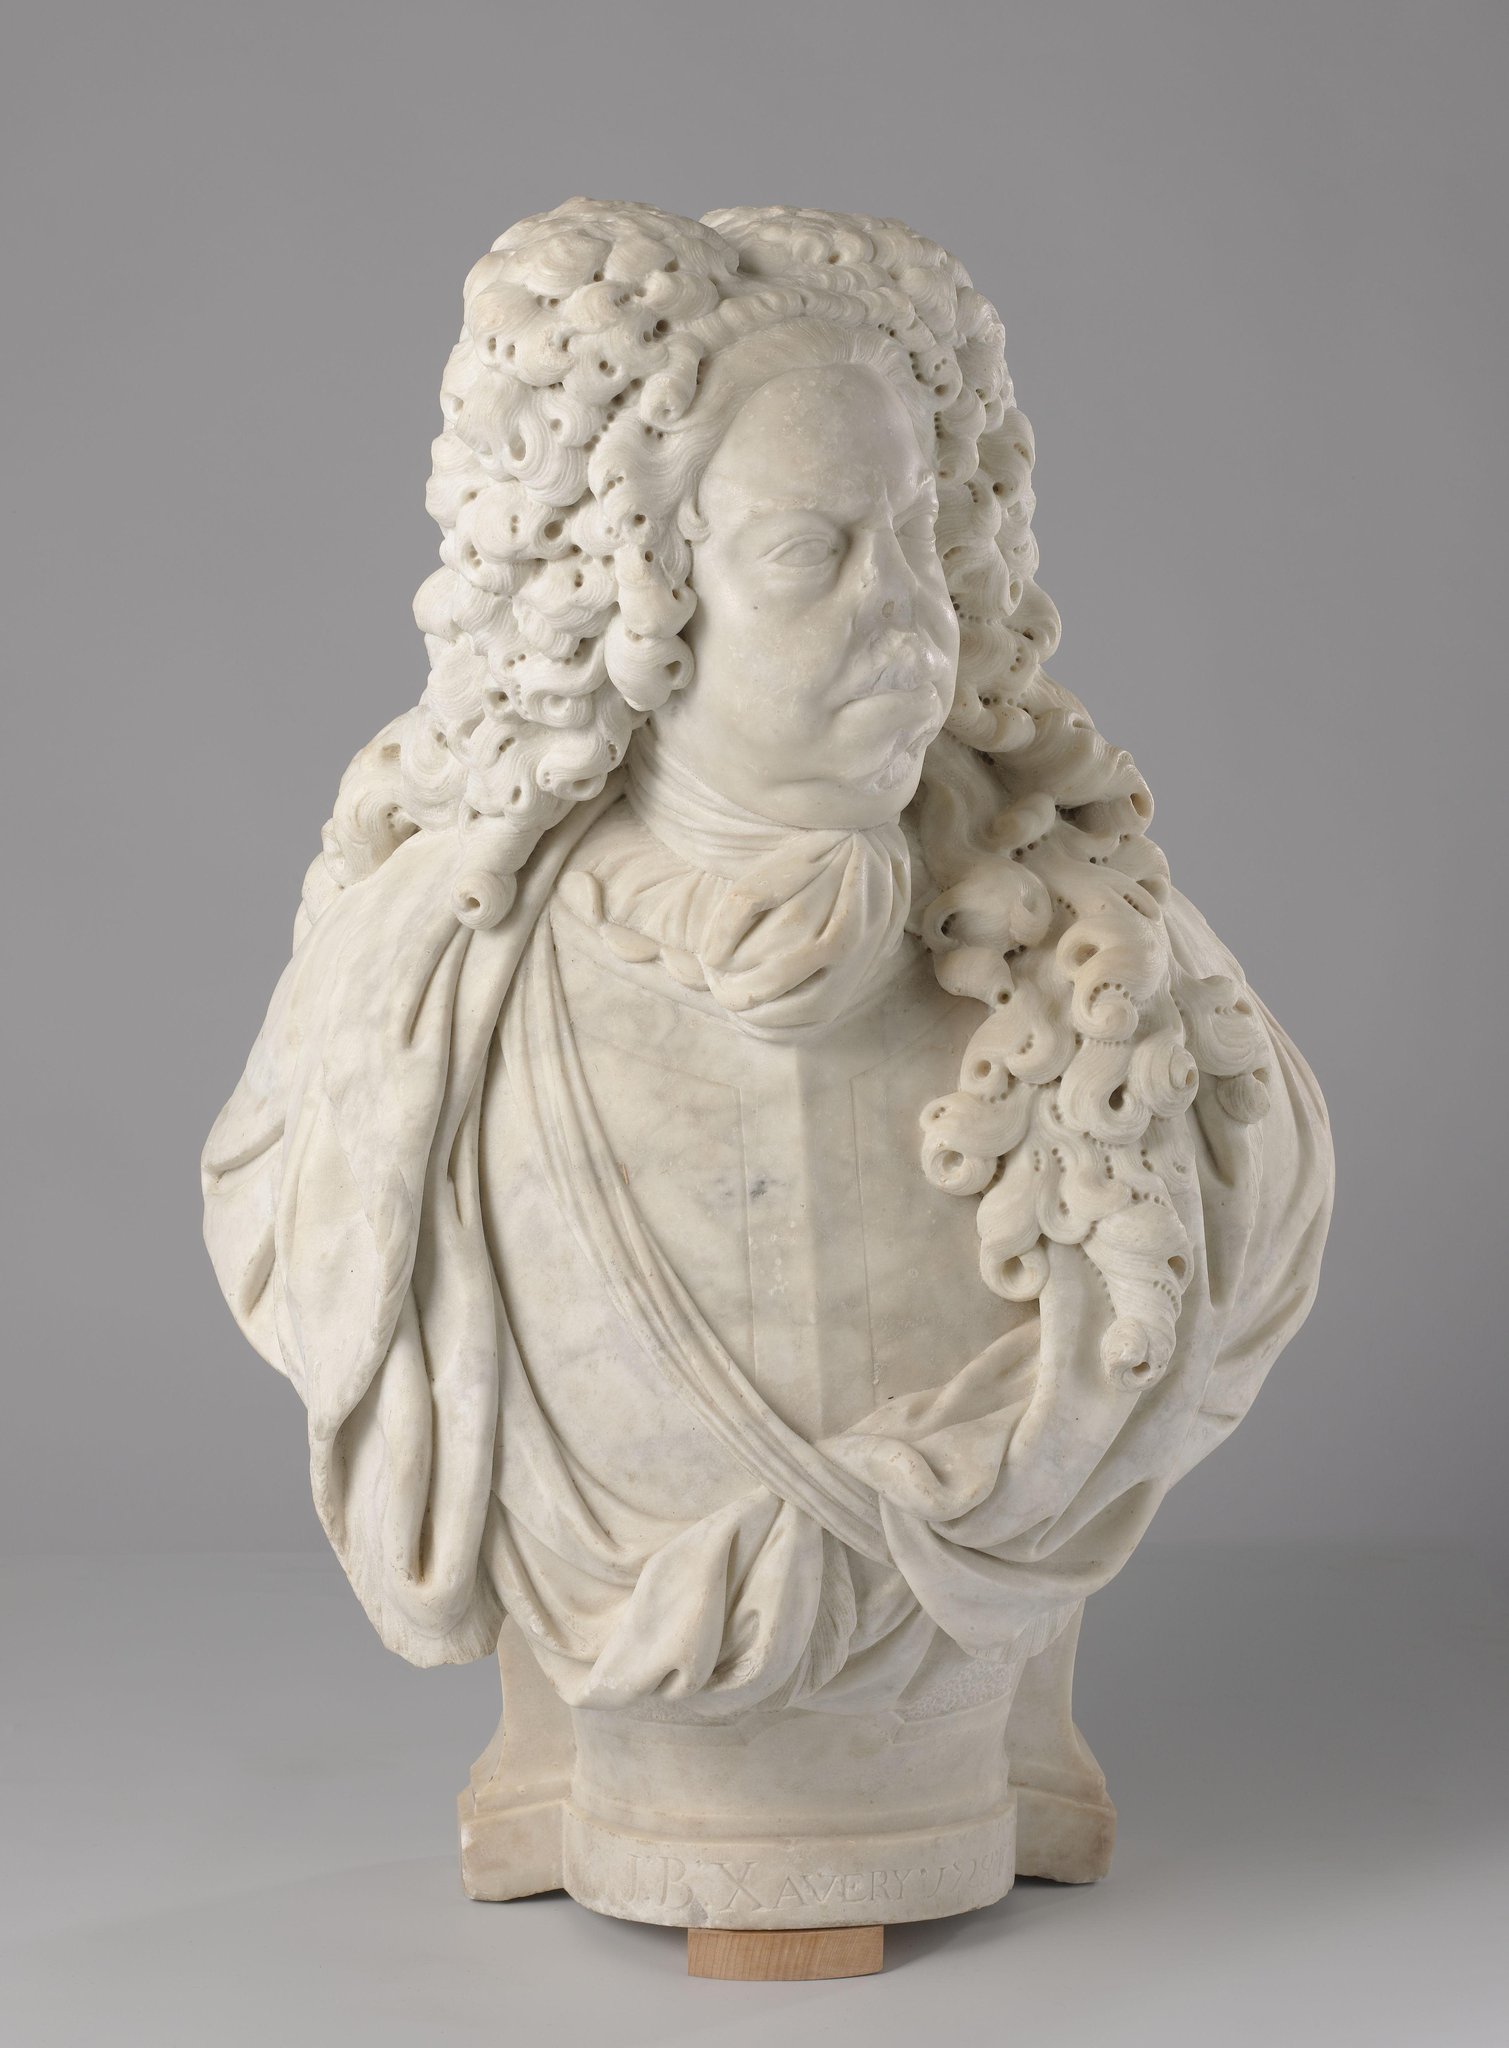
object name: sculpture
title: Bust of Johan van Welderen, Lord of Ubbergen, Valburg and Oudenhoorn (1660-1724)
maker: jan baptist xavery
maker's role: sculptor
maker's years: 1697-1742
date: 1728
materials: marble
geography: the hague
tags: mayor